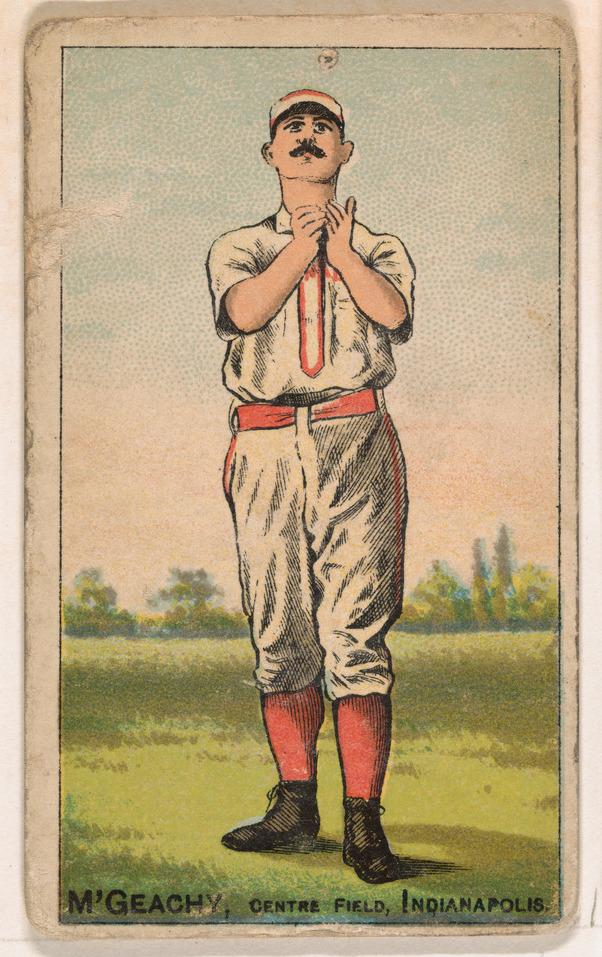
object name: baseball card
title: M'Geachy, Center Field, Indianapolis, from the Gold Coin series (N284) for Gold Coin Chewing Tobacco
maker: d. buchner & co., new york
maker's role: publisher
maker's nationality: american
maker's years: 1850-1900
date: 1887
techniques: color lithograph, drawing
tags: men,baseball,athletes